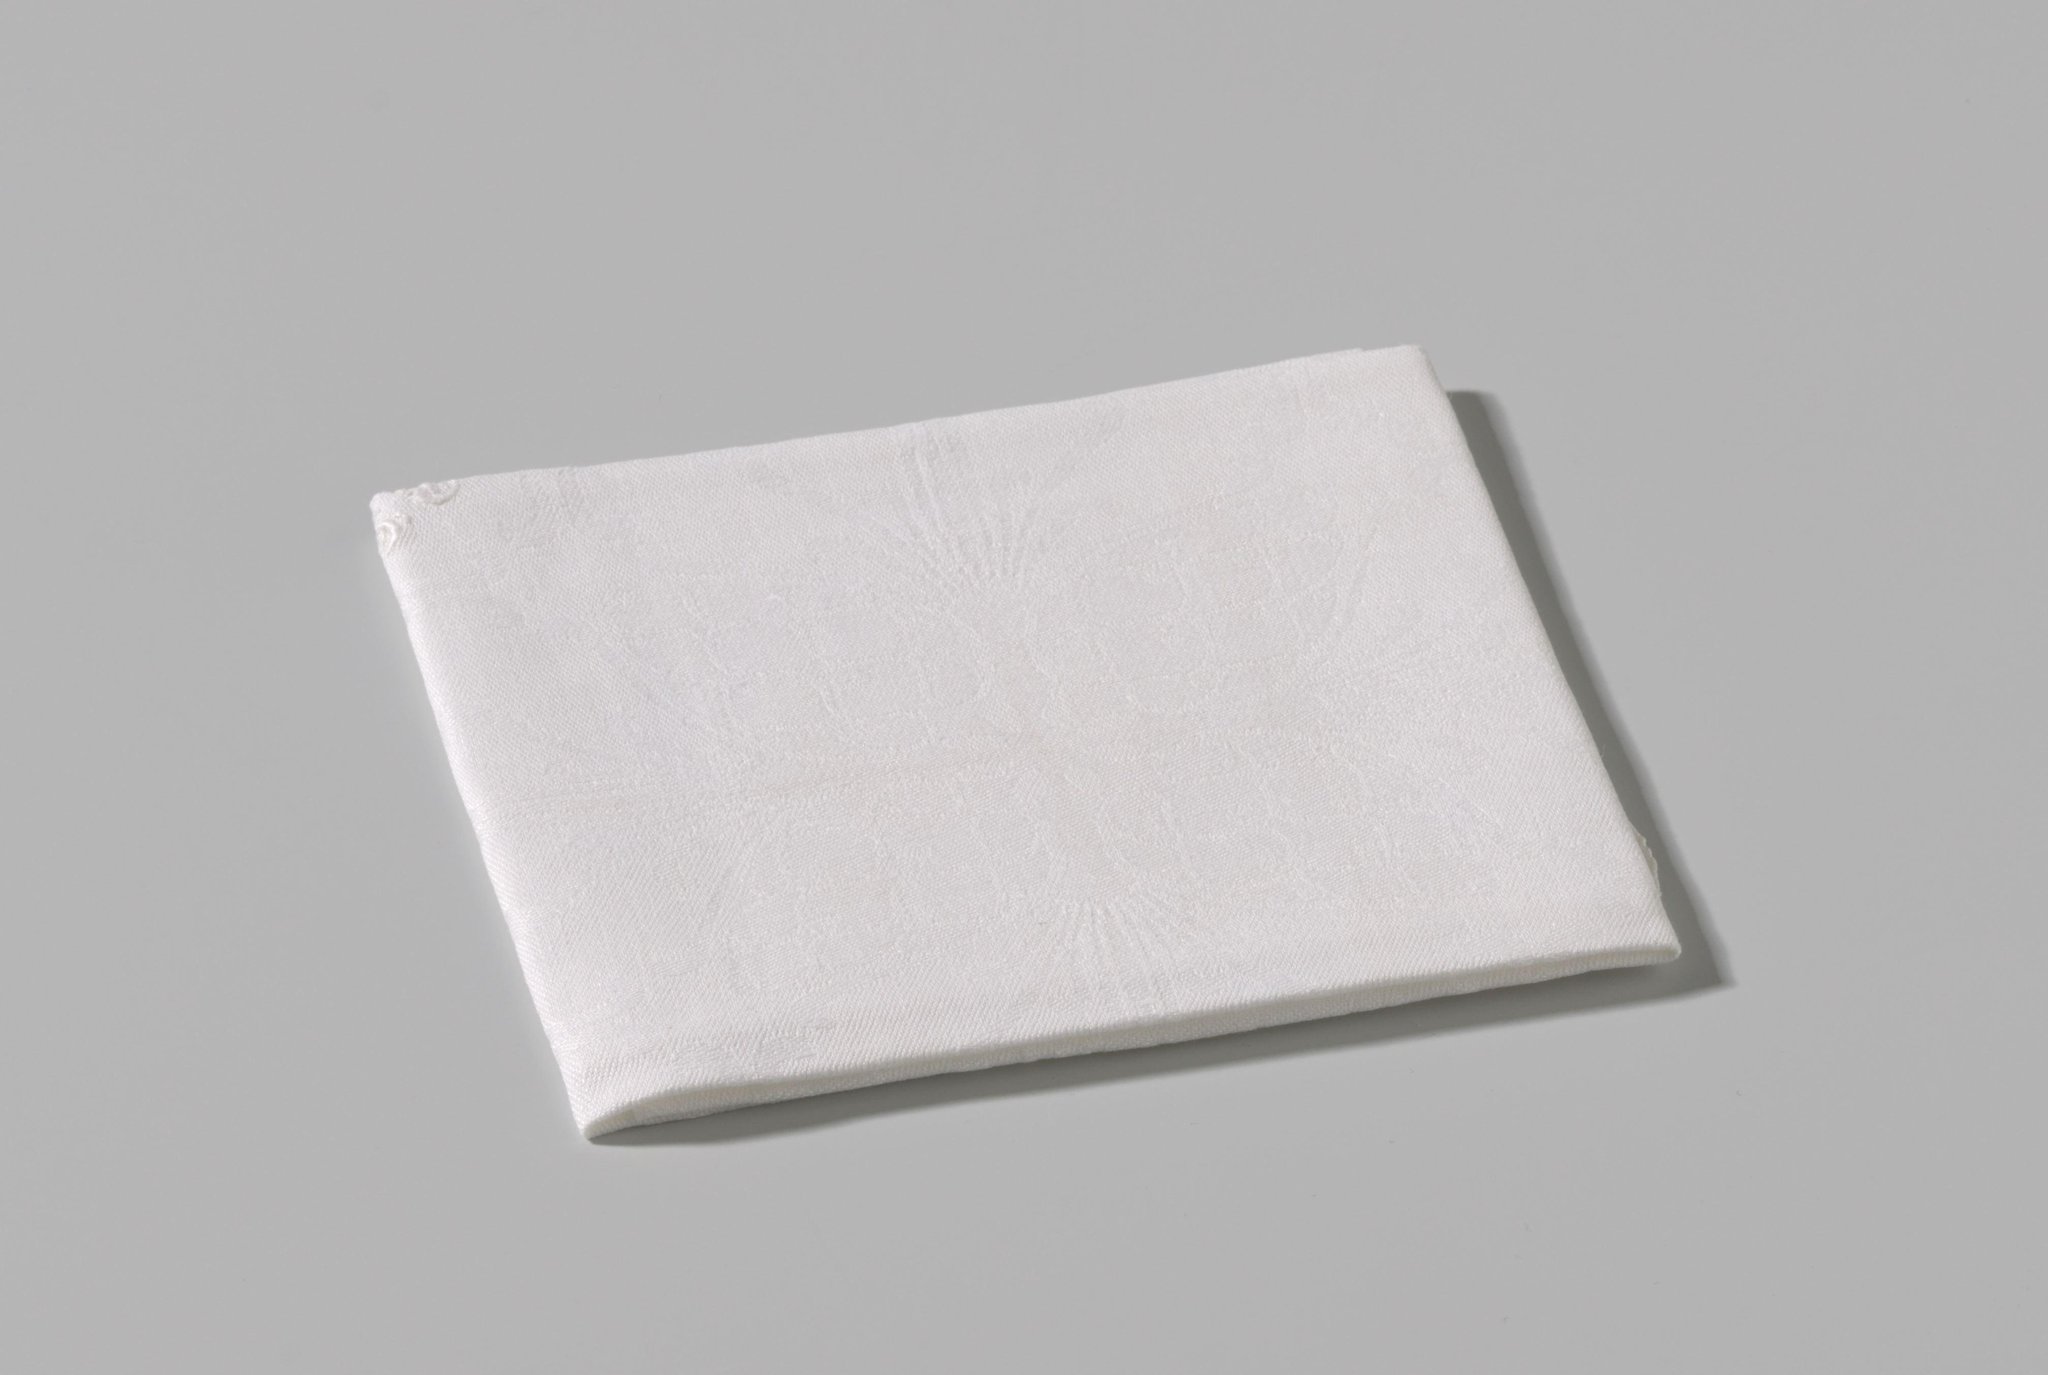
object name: vingerdoek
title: Vingerdoek van linnendamast met motief Naaldenveld, dessin 607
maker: chris lebeau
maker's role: draughtsman, print maker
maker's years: 1878-1945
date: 1900-1925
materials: linen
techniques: damask, weave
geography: eindhoven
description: Vingerdoek van linnendamast met dessin 607; motief "naaldenveld". De vingerdoek hoort bij elf vingerdoeken (BK-1973-179-A t/m BK-1973-178-L) en een tafellaken (BK-1973-178).